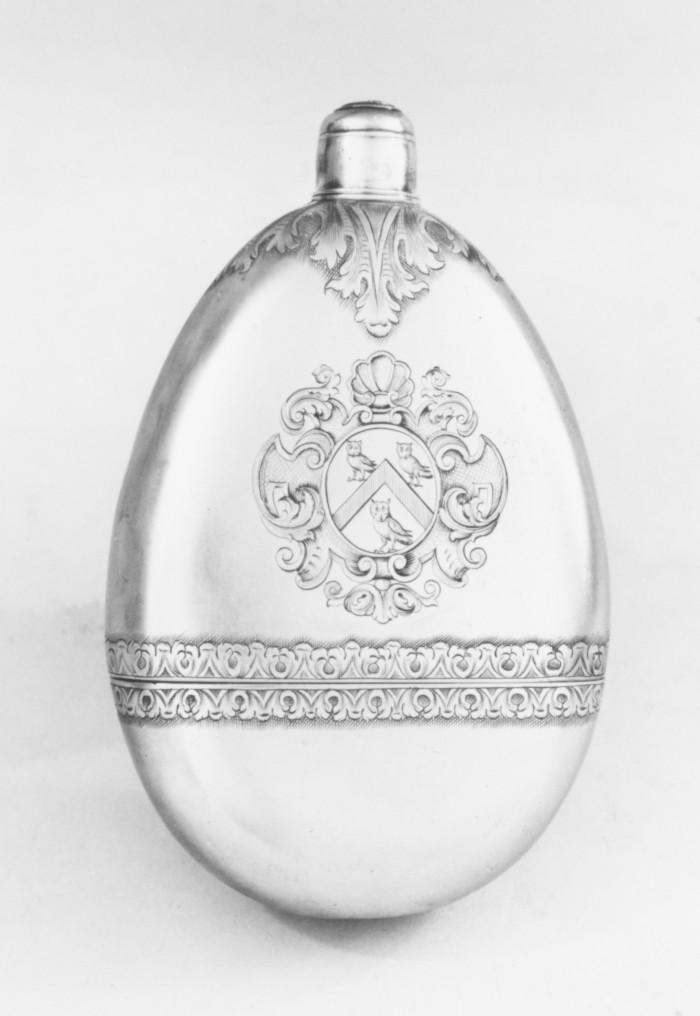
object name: flask with screw top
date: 1710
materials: silver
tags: birds,coat of arms